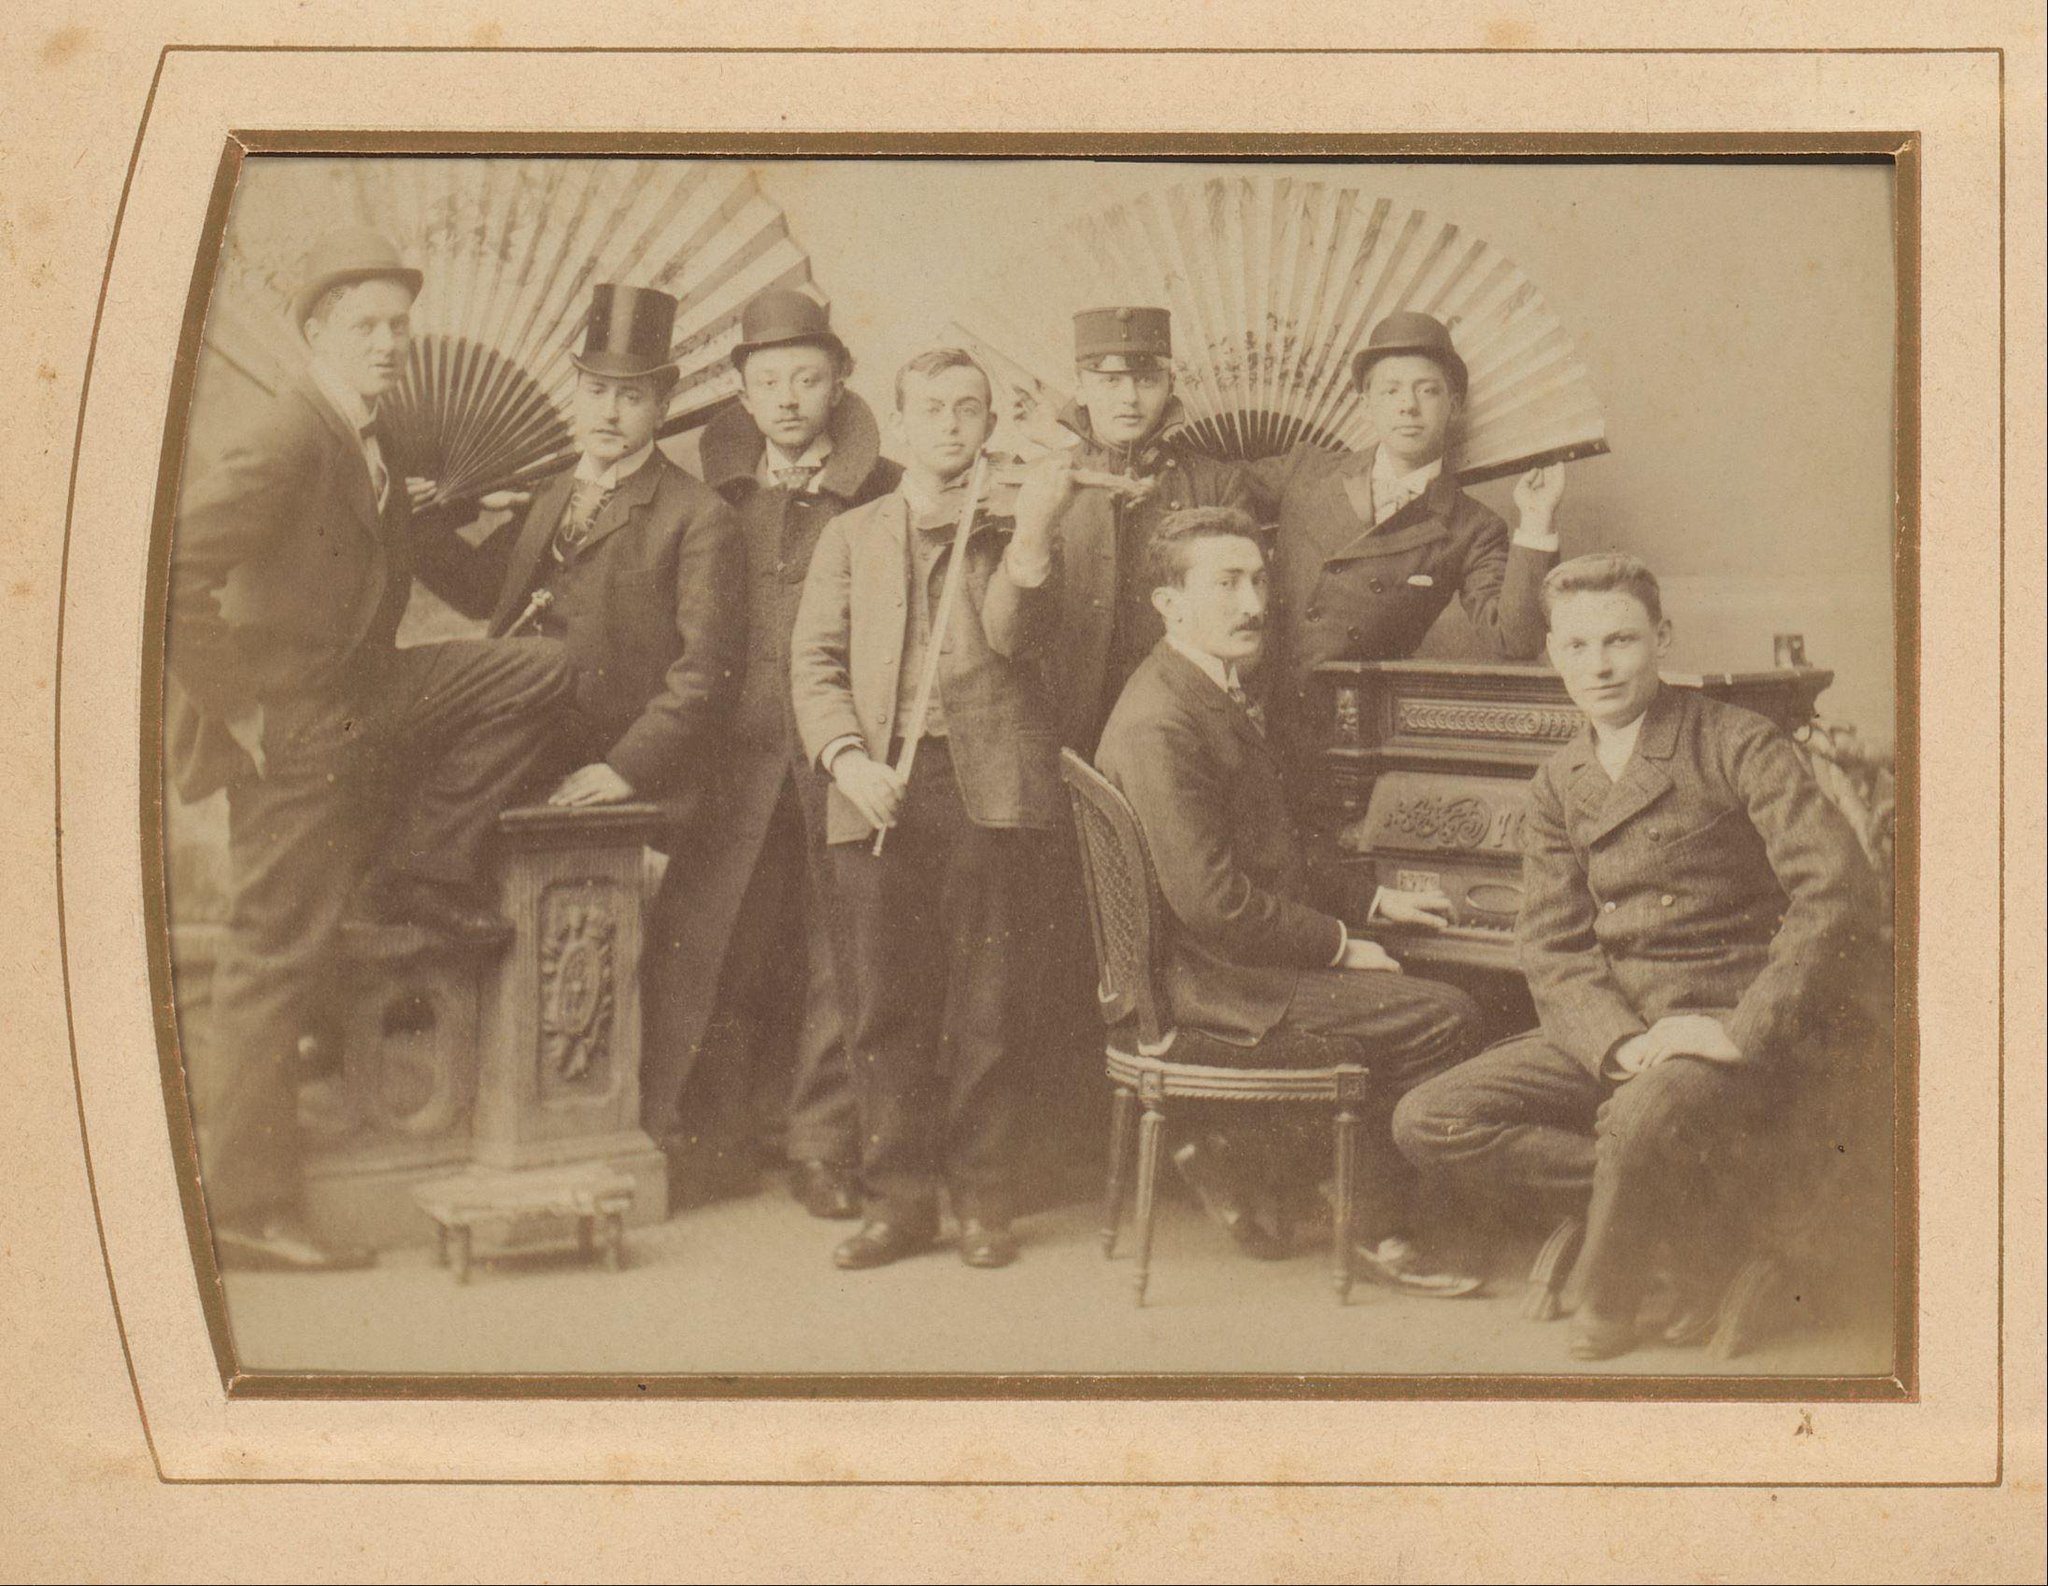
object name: album leaf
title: Groepsfoto van studenten met muziekinstrumenten, achter de piano zit François Buys, naast hem met pet staat Evert Verschuyl en links met hoge hoed staat Anton Buys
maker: albert greiner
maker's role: fotograaf, fotostudio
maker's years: 1833-1890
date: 1880-1887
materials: cardboard, paper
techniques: albumen print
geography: amsterdam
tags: françois buys, musical instruments; group of musical instruments, historical persons, student life, anonymous historical persons portrayed in a group, in a group-portrait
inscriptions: address: ‘Amsterdam/ NIEUWENDIJK 89.’